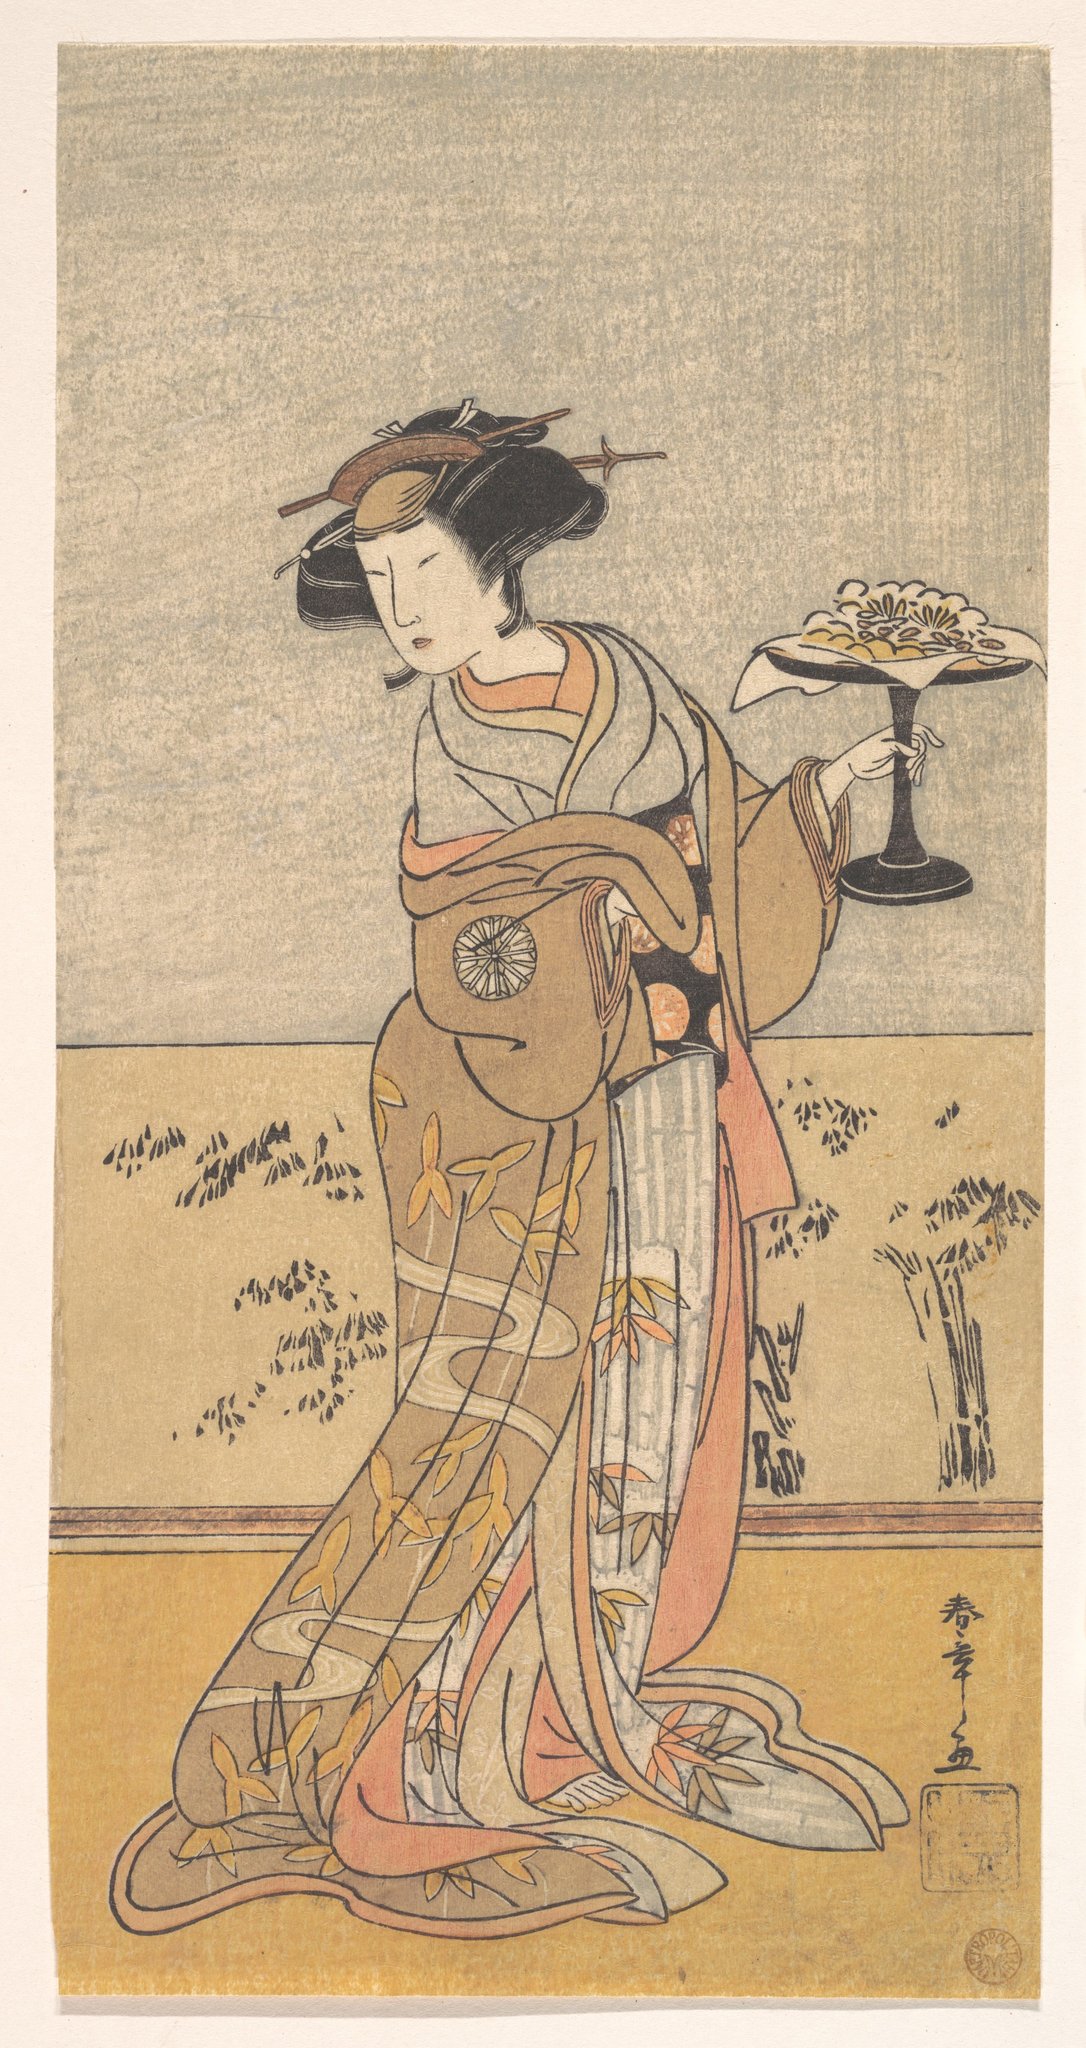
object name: woodblock print nishiki e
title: Kabuki Actor Nakamura Tomijūrō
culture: japanese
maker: katsukawa shunshō 勝川春章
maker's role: artist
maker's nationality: japanese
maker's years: 1726-1792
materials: ink, paper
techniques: nishiki e, woodblock print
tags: human figures,actors